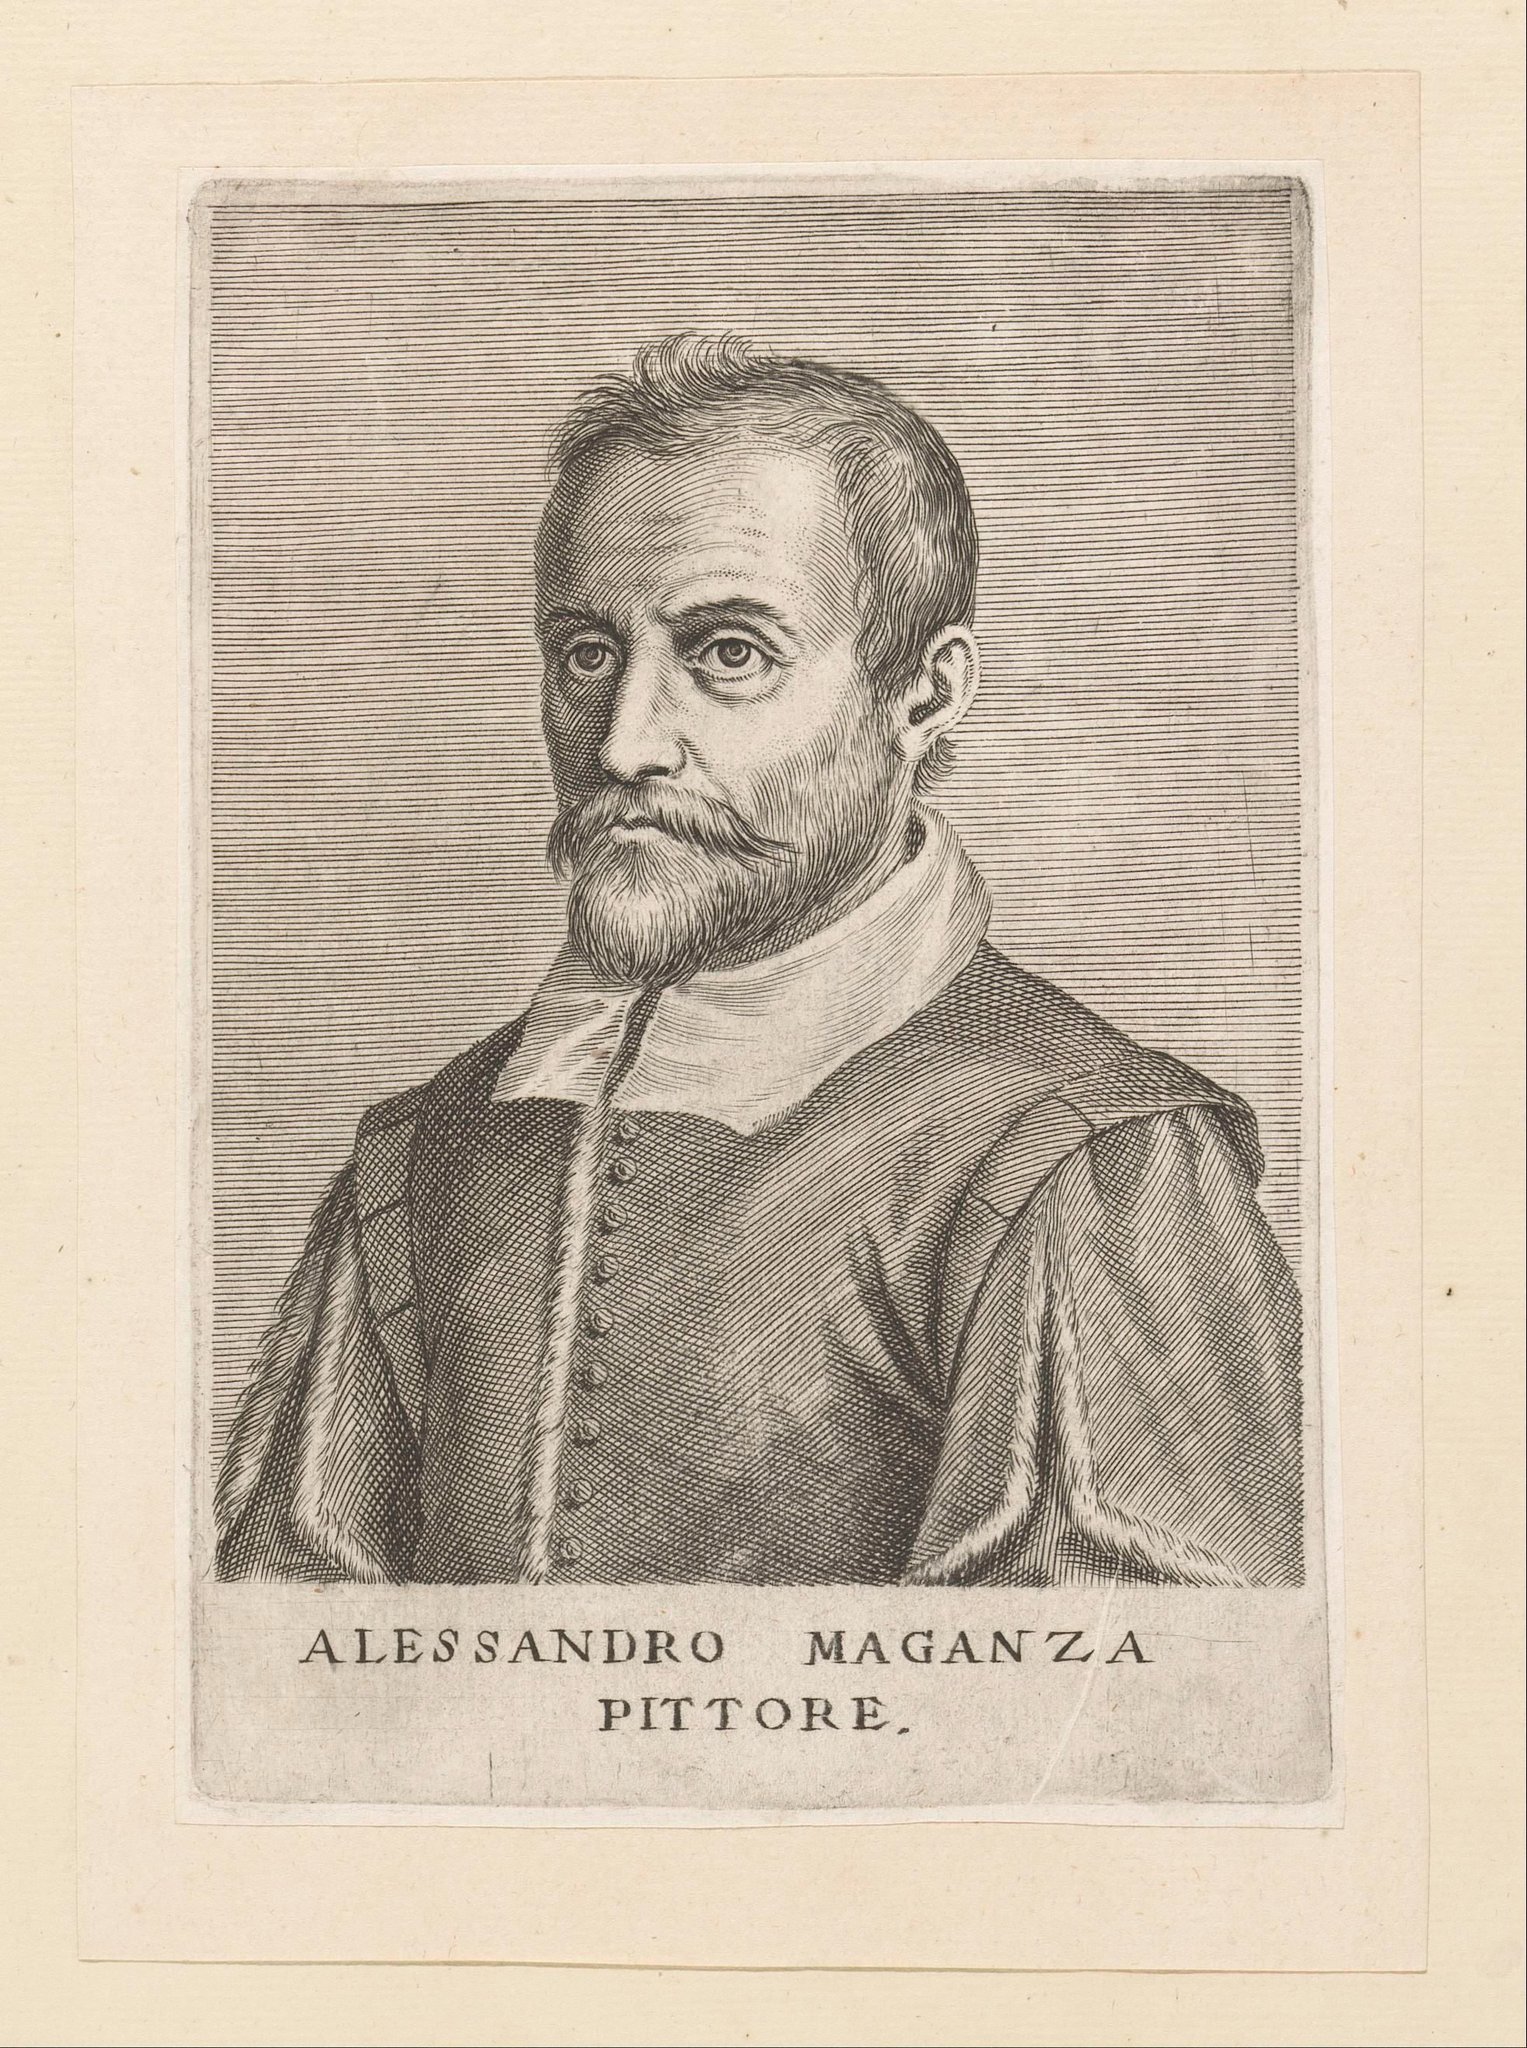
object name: print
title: Portretten van beroemde Italiaanse schilders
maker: monogrammist ip (italië)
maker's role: print maker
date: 1600-1699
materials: paper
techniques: engraving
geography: italy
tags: draughtsman, historical persons, portrait, self-portrait of artist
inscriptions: collector's mark: Lugt 2228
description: Deze prent maakt deel uit van een reeks van ten minste negen portretten van beroemde Italiaanse schilders.